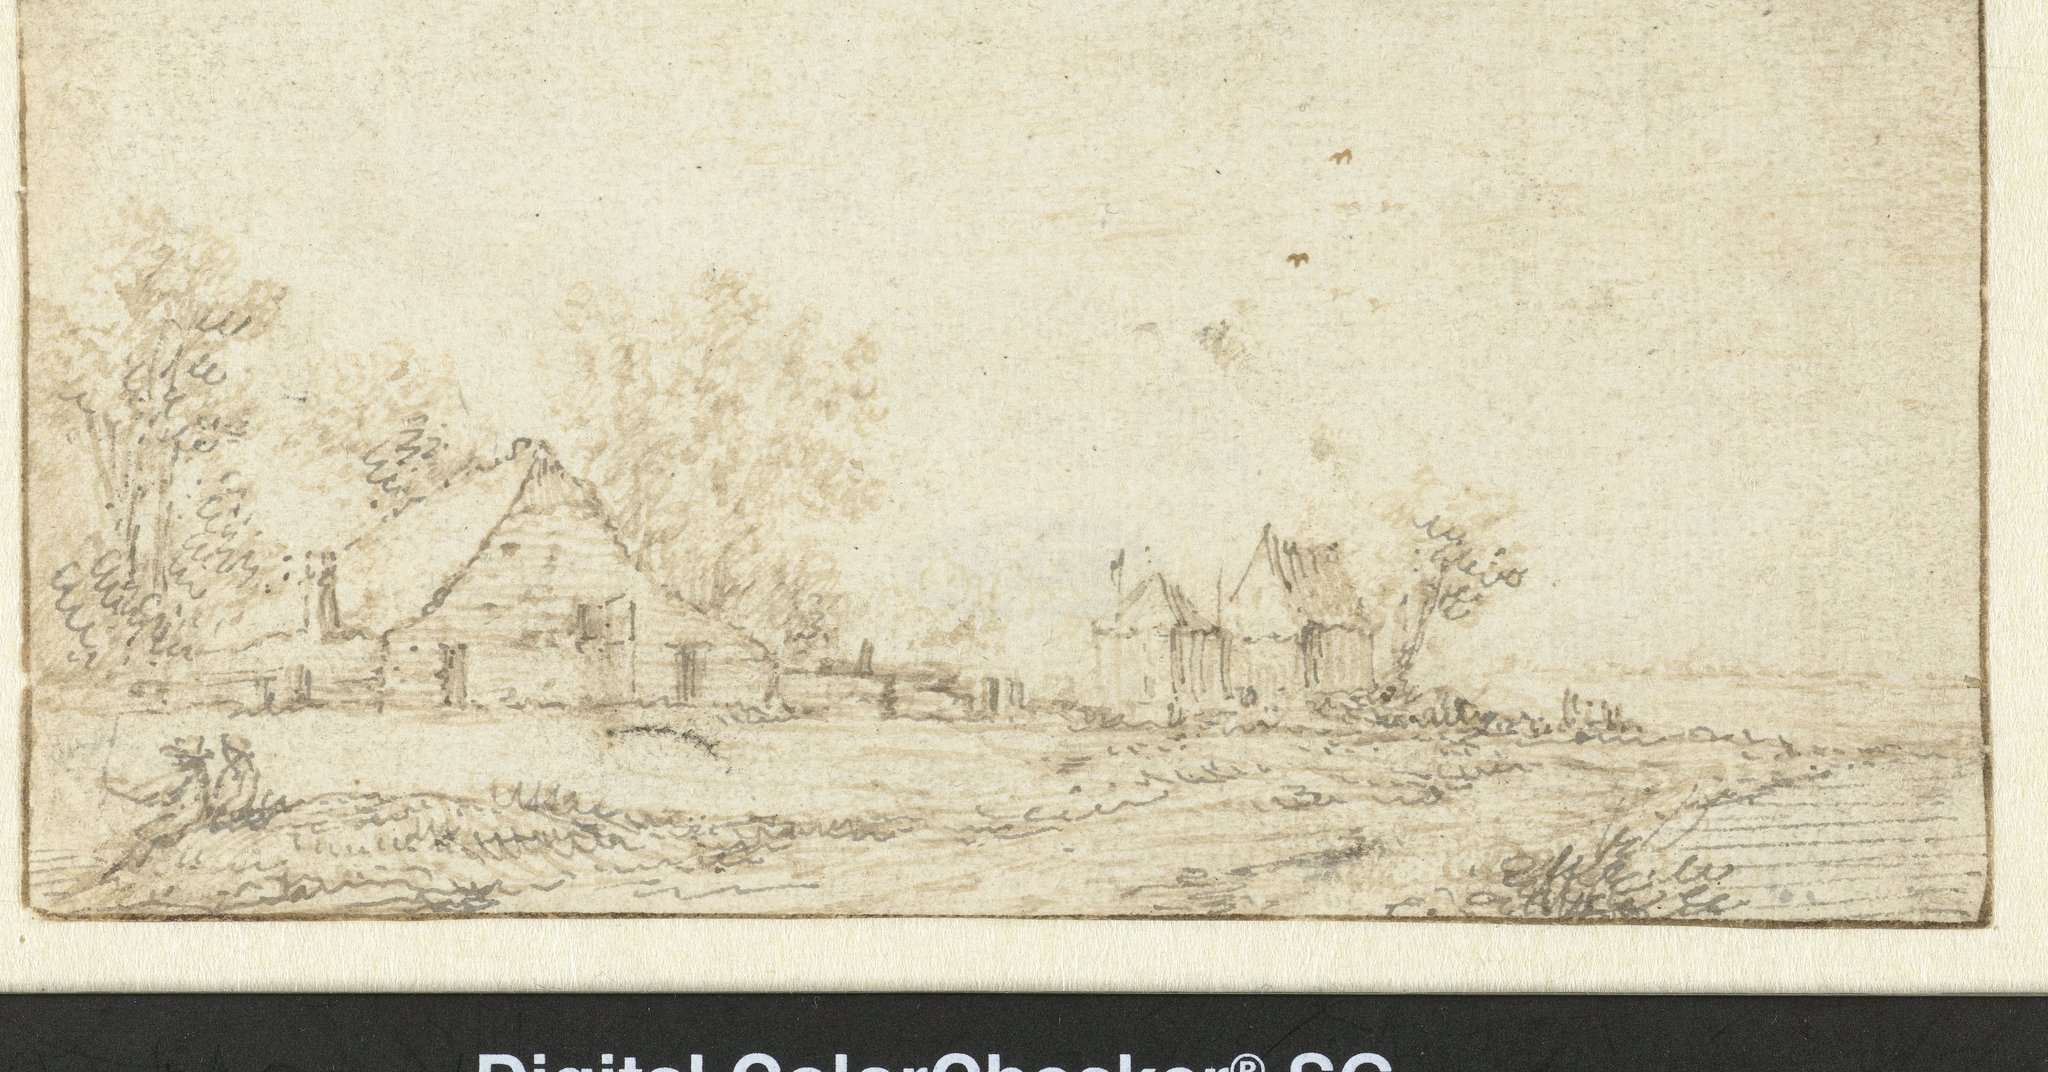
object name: drawing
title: Landschap met hutjes aan een weg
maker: jan van goyen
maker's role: draughtsman, painter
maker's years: 1596-1656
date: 1606-1656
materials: ink, paper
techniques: pen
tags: farm or solitary house in landscape